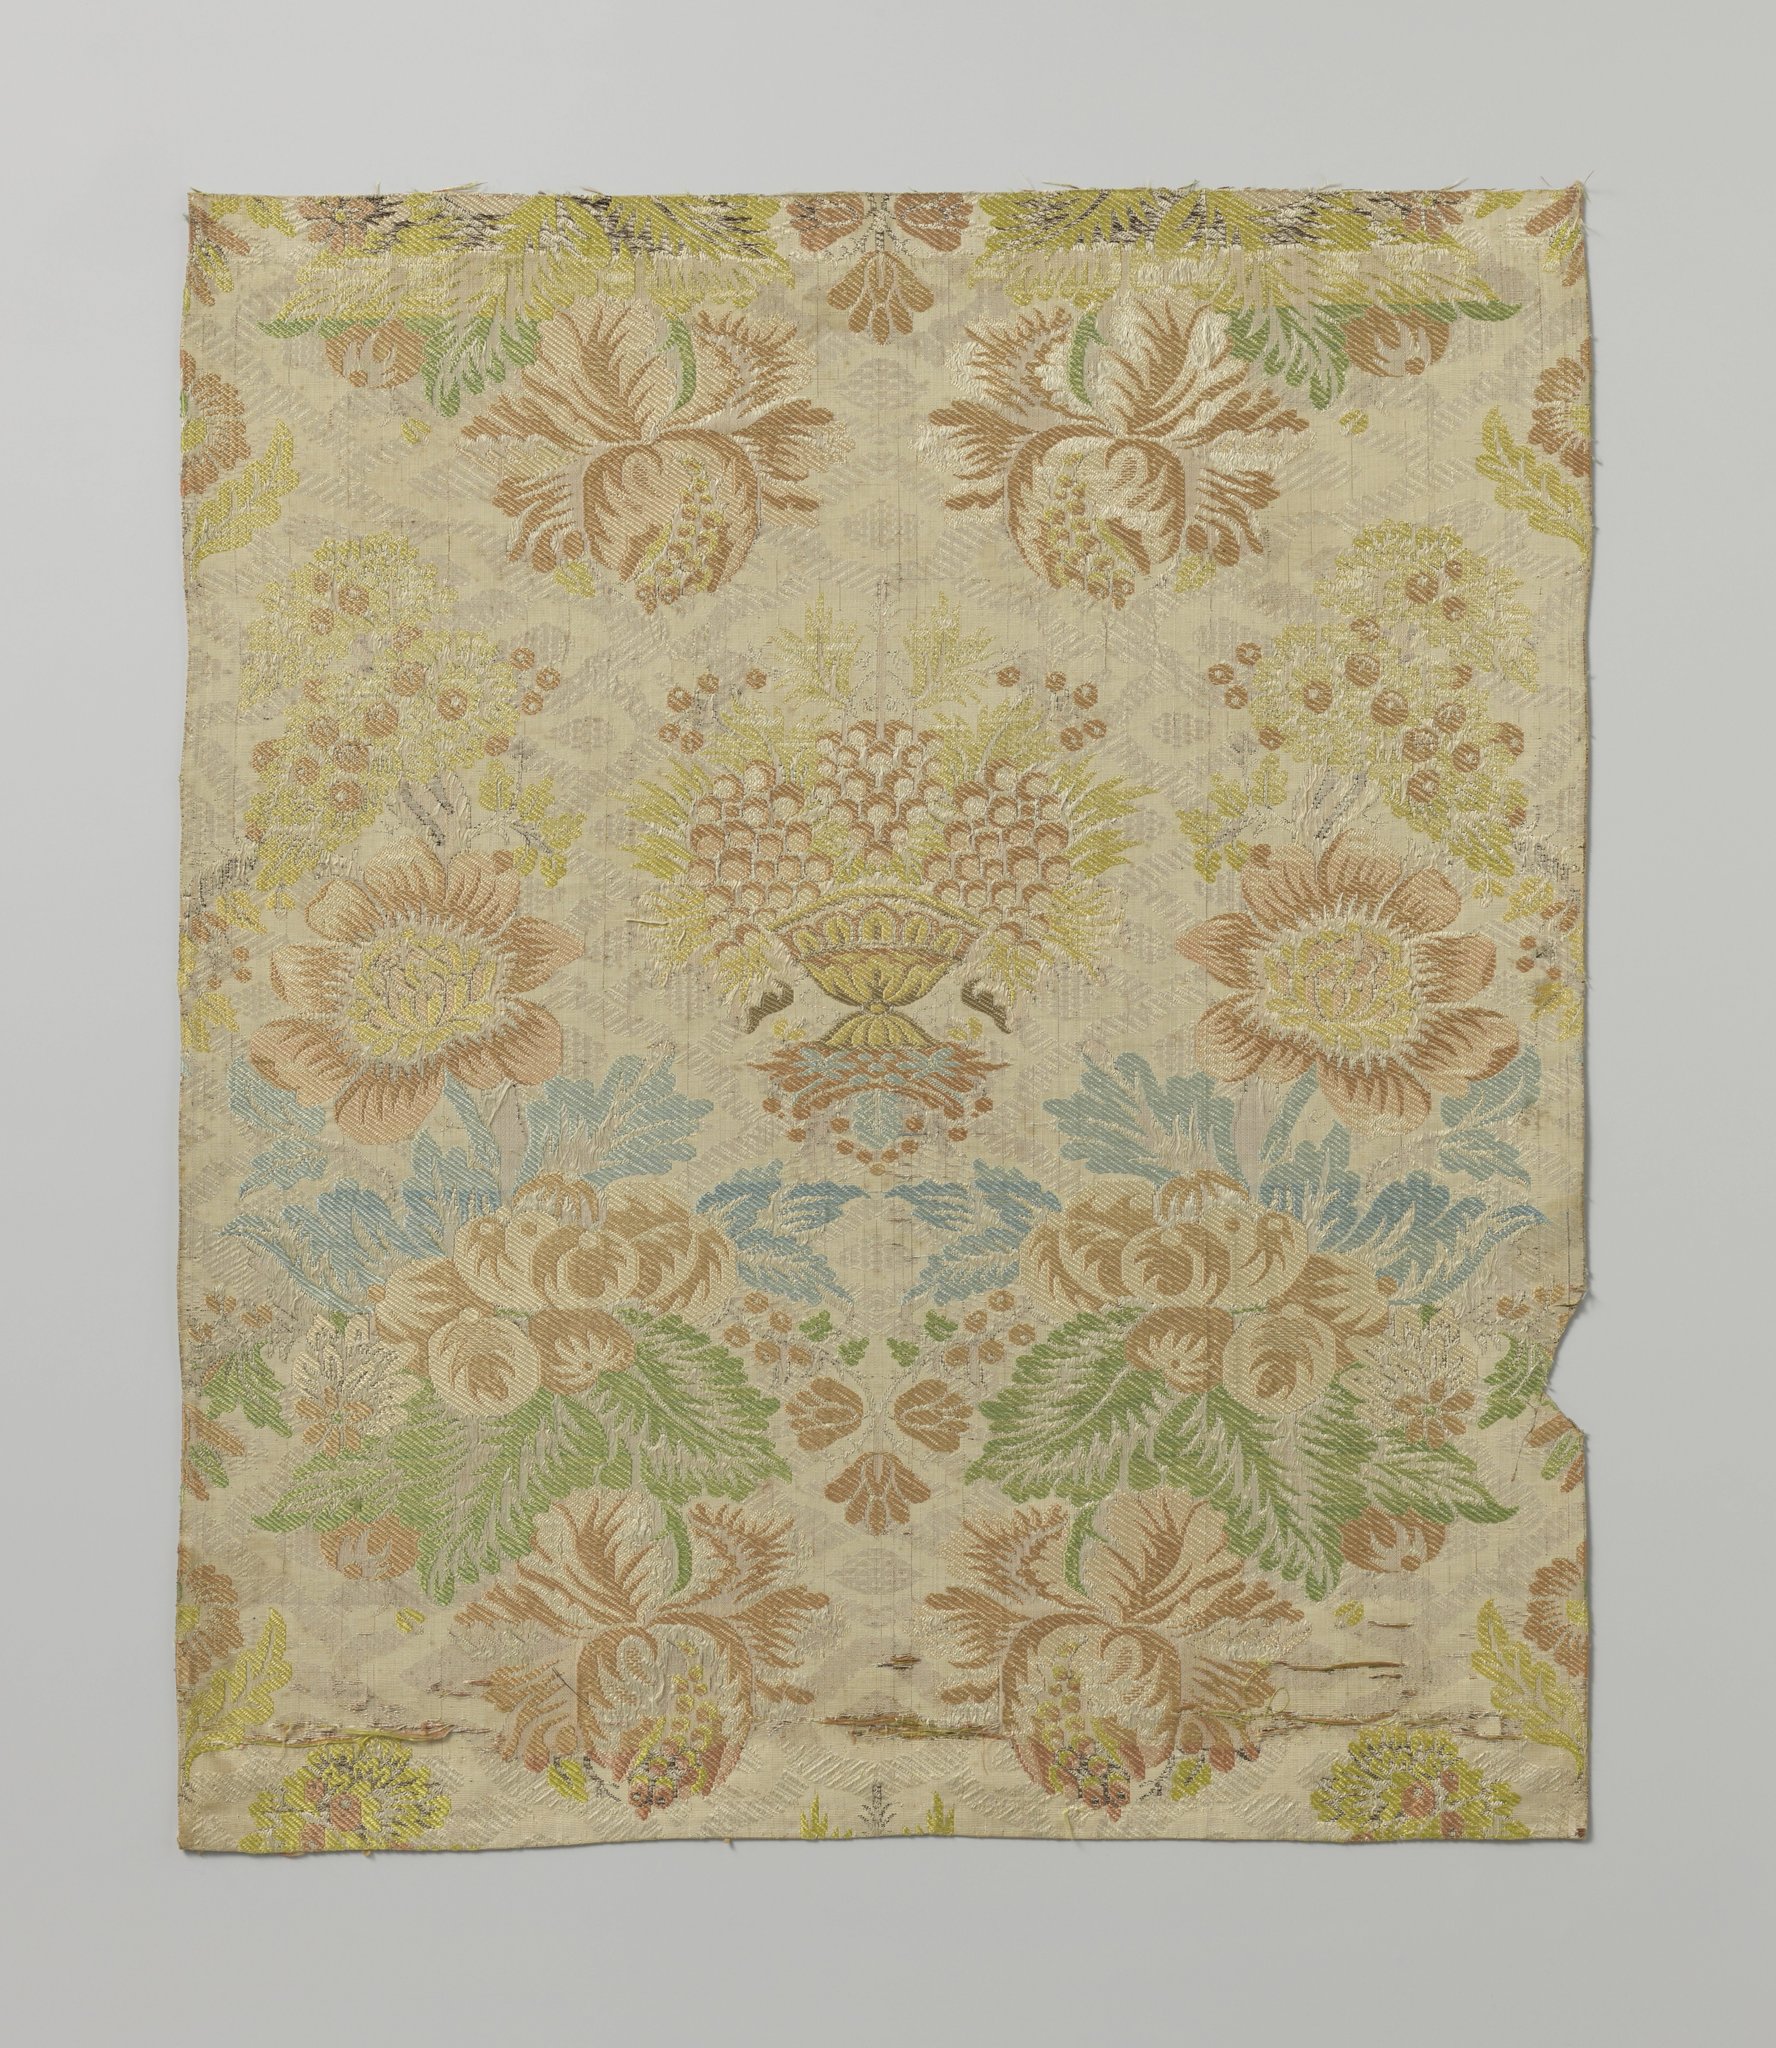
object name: fragment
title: Fragment veelkleurig gebrocheerde zijde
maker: Anonymous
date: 1740-1760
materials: silk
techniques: brocade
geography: lyon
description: Een fragment. Grond van wit zijdeweefsel met gekleurde bloemen en vruchten. Opmerking: Zelfkant; 0.5 cm effenbinding, (inslag 4 kleuren).